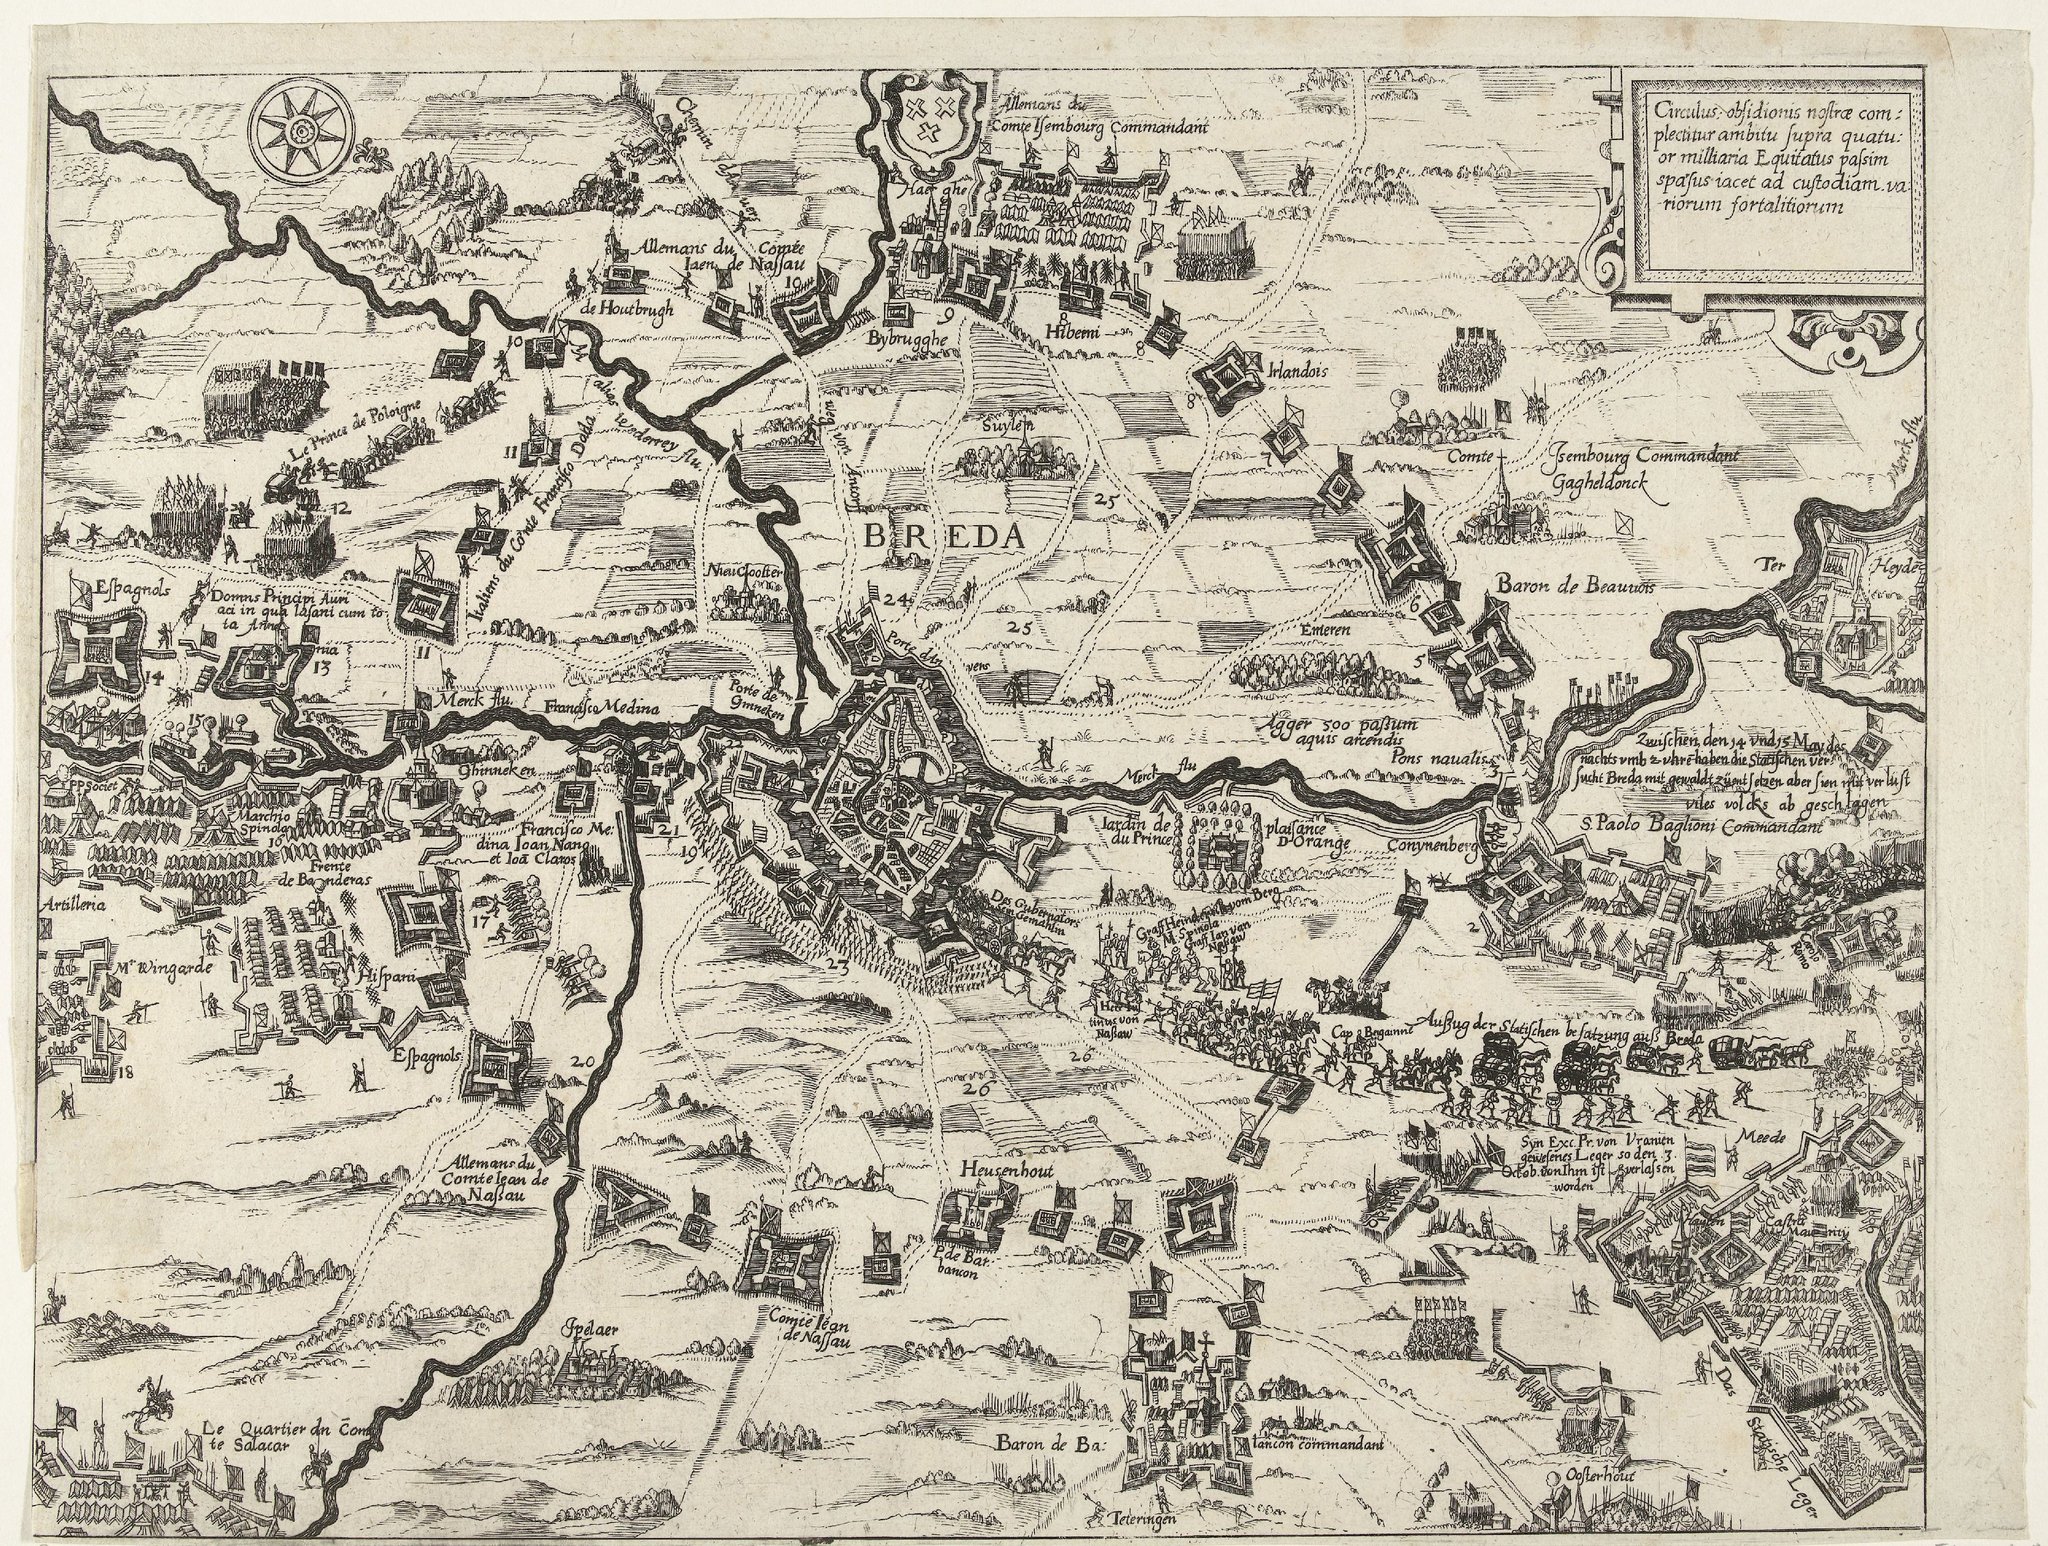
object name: print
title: Kaart van het beleg van Breda, 1624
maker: Anonymous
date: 1624-1625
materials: paper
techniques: etching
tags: maps of separate countries or regions, siege, position war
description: Kaart van het beleg van Breda door het Spaanse leger onder Spinola, 27 augustus 1624 tot 5 juni 1625. Breda met het omliggende land. Linksonder de legerplaats bij Ginneken, rechts Ter Heijde. Rechts de uittocht van het Staatse leger met Justinus van Nassau uit Breda. Rechtsonder de verlaten legerplaats van het Staatse leger onder Maurits. Opschriften in de voorstelling in het Duits en Frans.